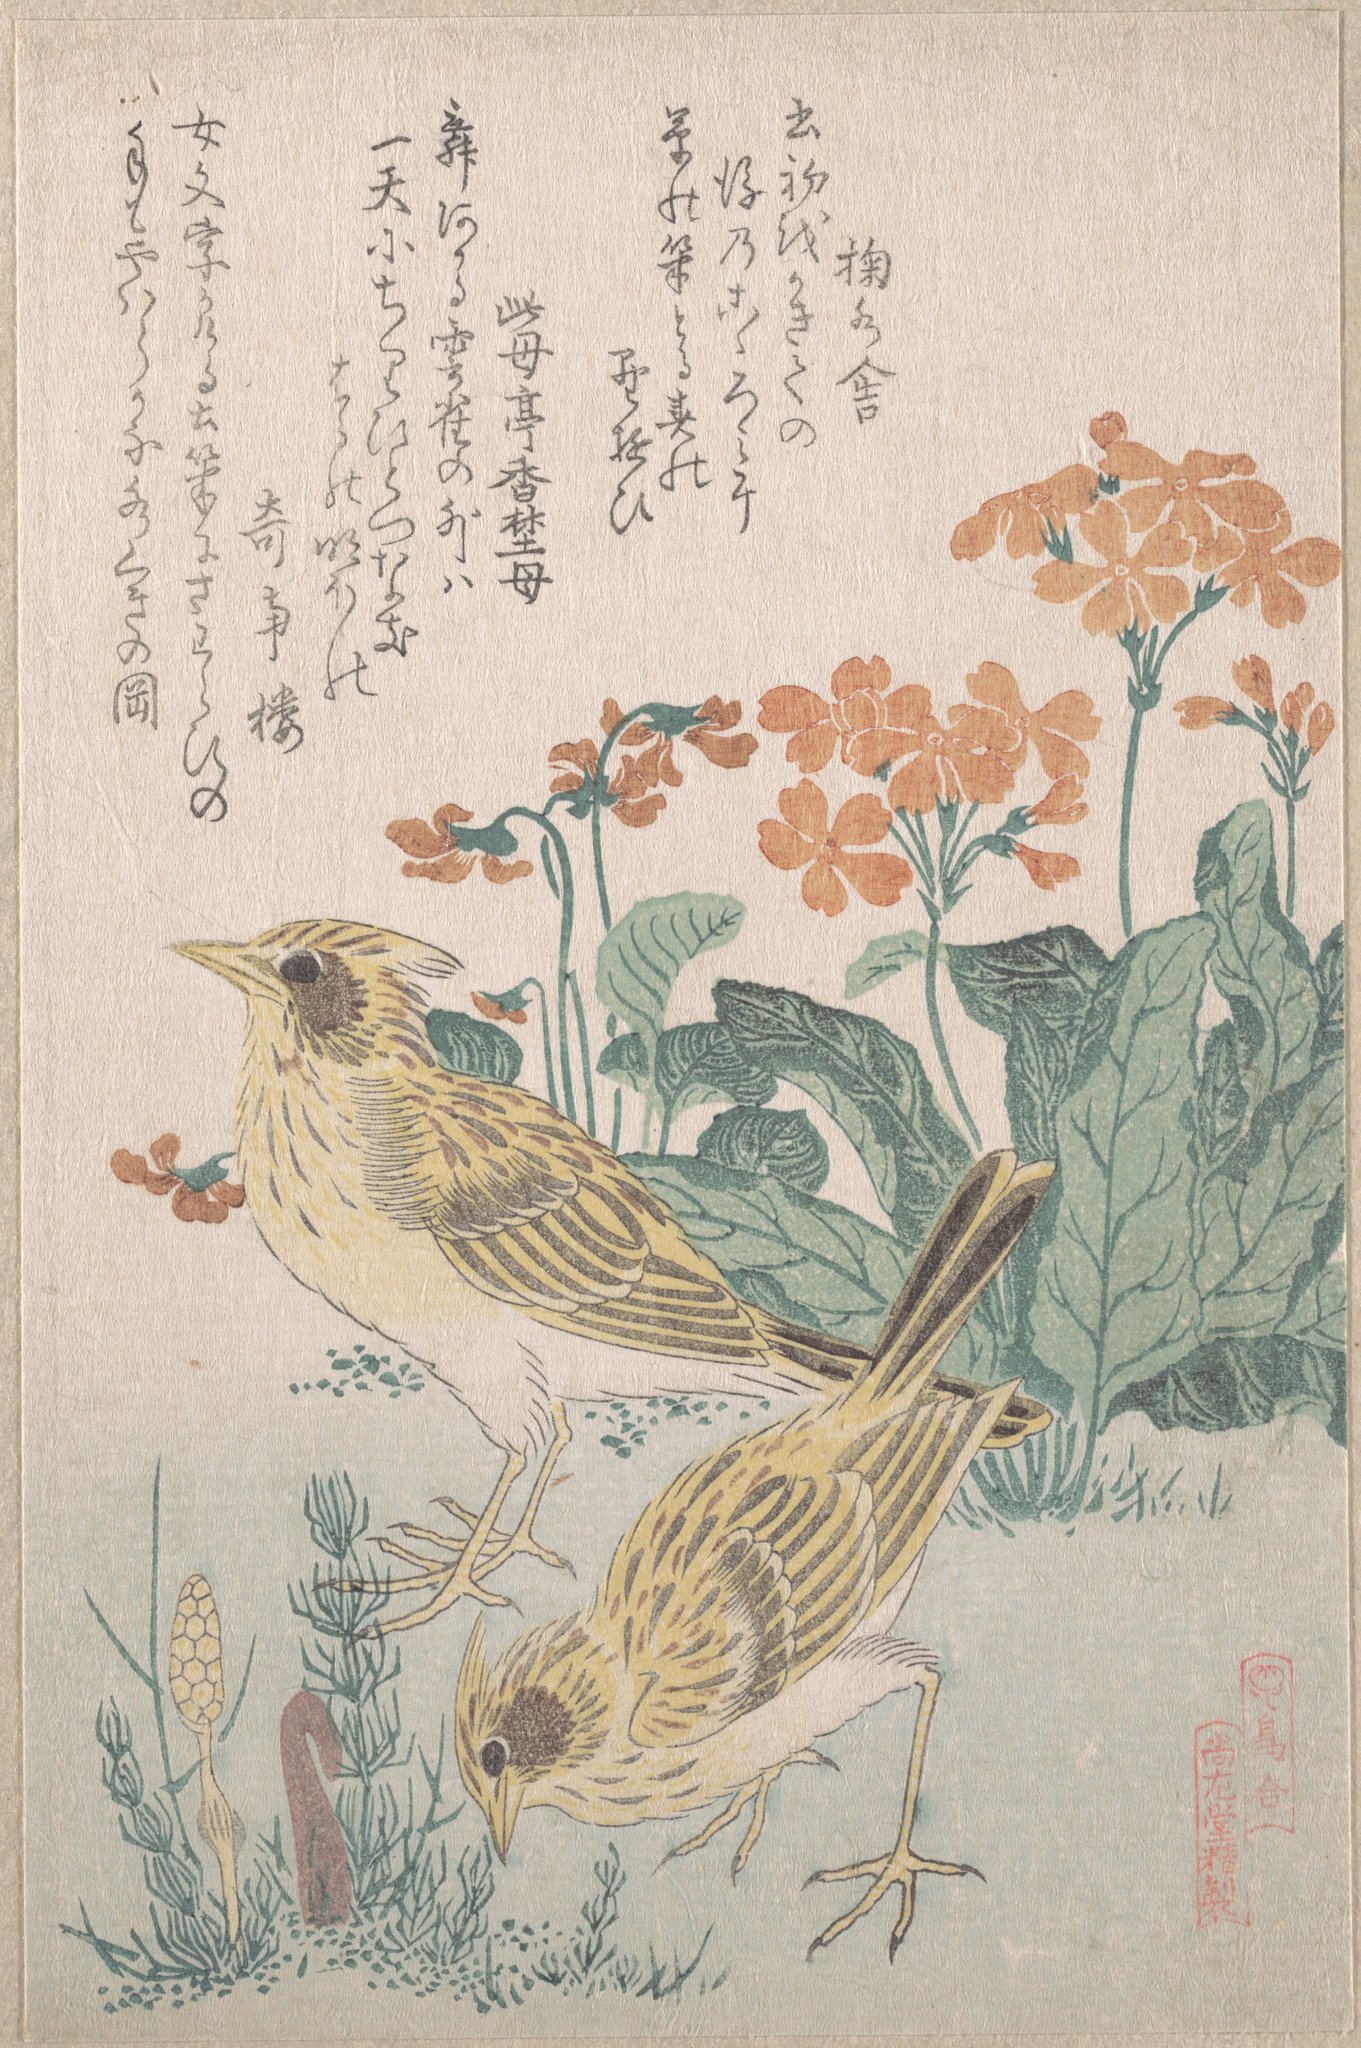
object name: print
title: Skylarks and Primroses,” from the Series An Array of Birds (Tori awase), from Spring Rain Surimono Album (Harusame surimono-jō, vol. 3)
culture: japanese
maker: kubo shunman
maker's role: artist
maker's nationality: japanese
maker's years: 1757-1820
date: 1805-1810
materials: ink, paper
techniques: surimono, woodblock print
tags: birds,flowers,leaves